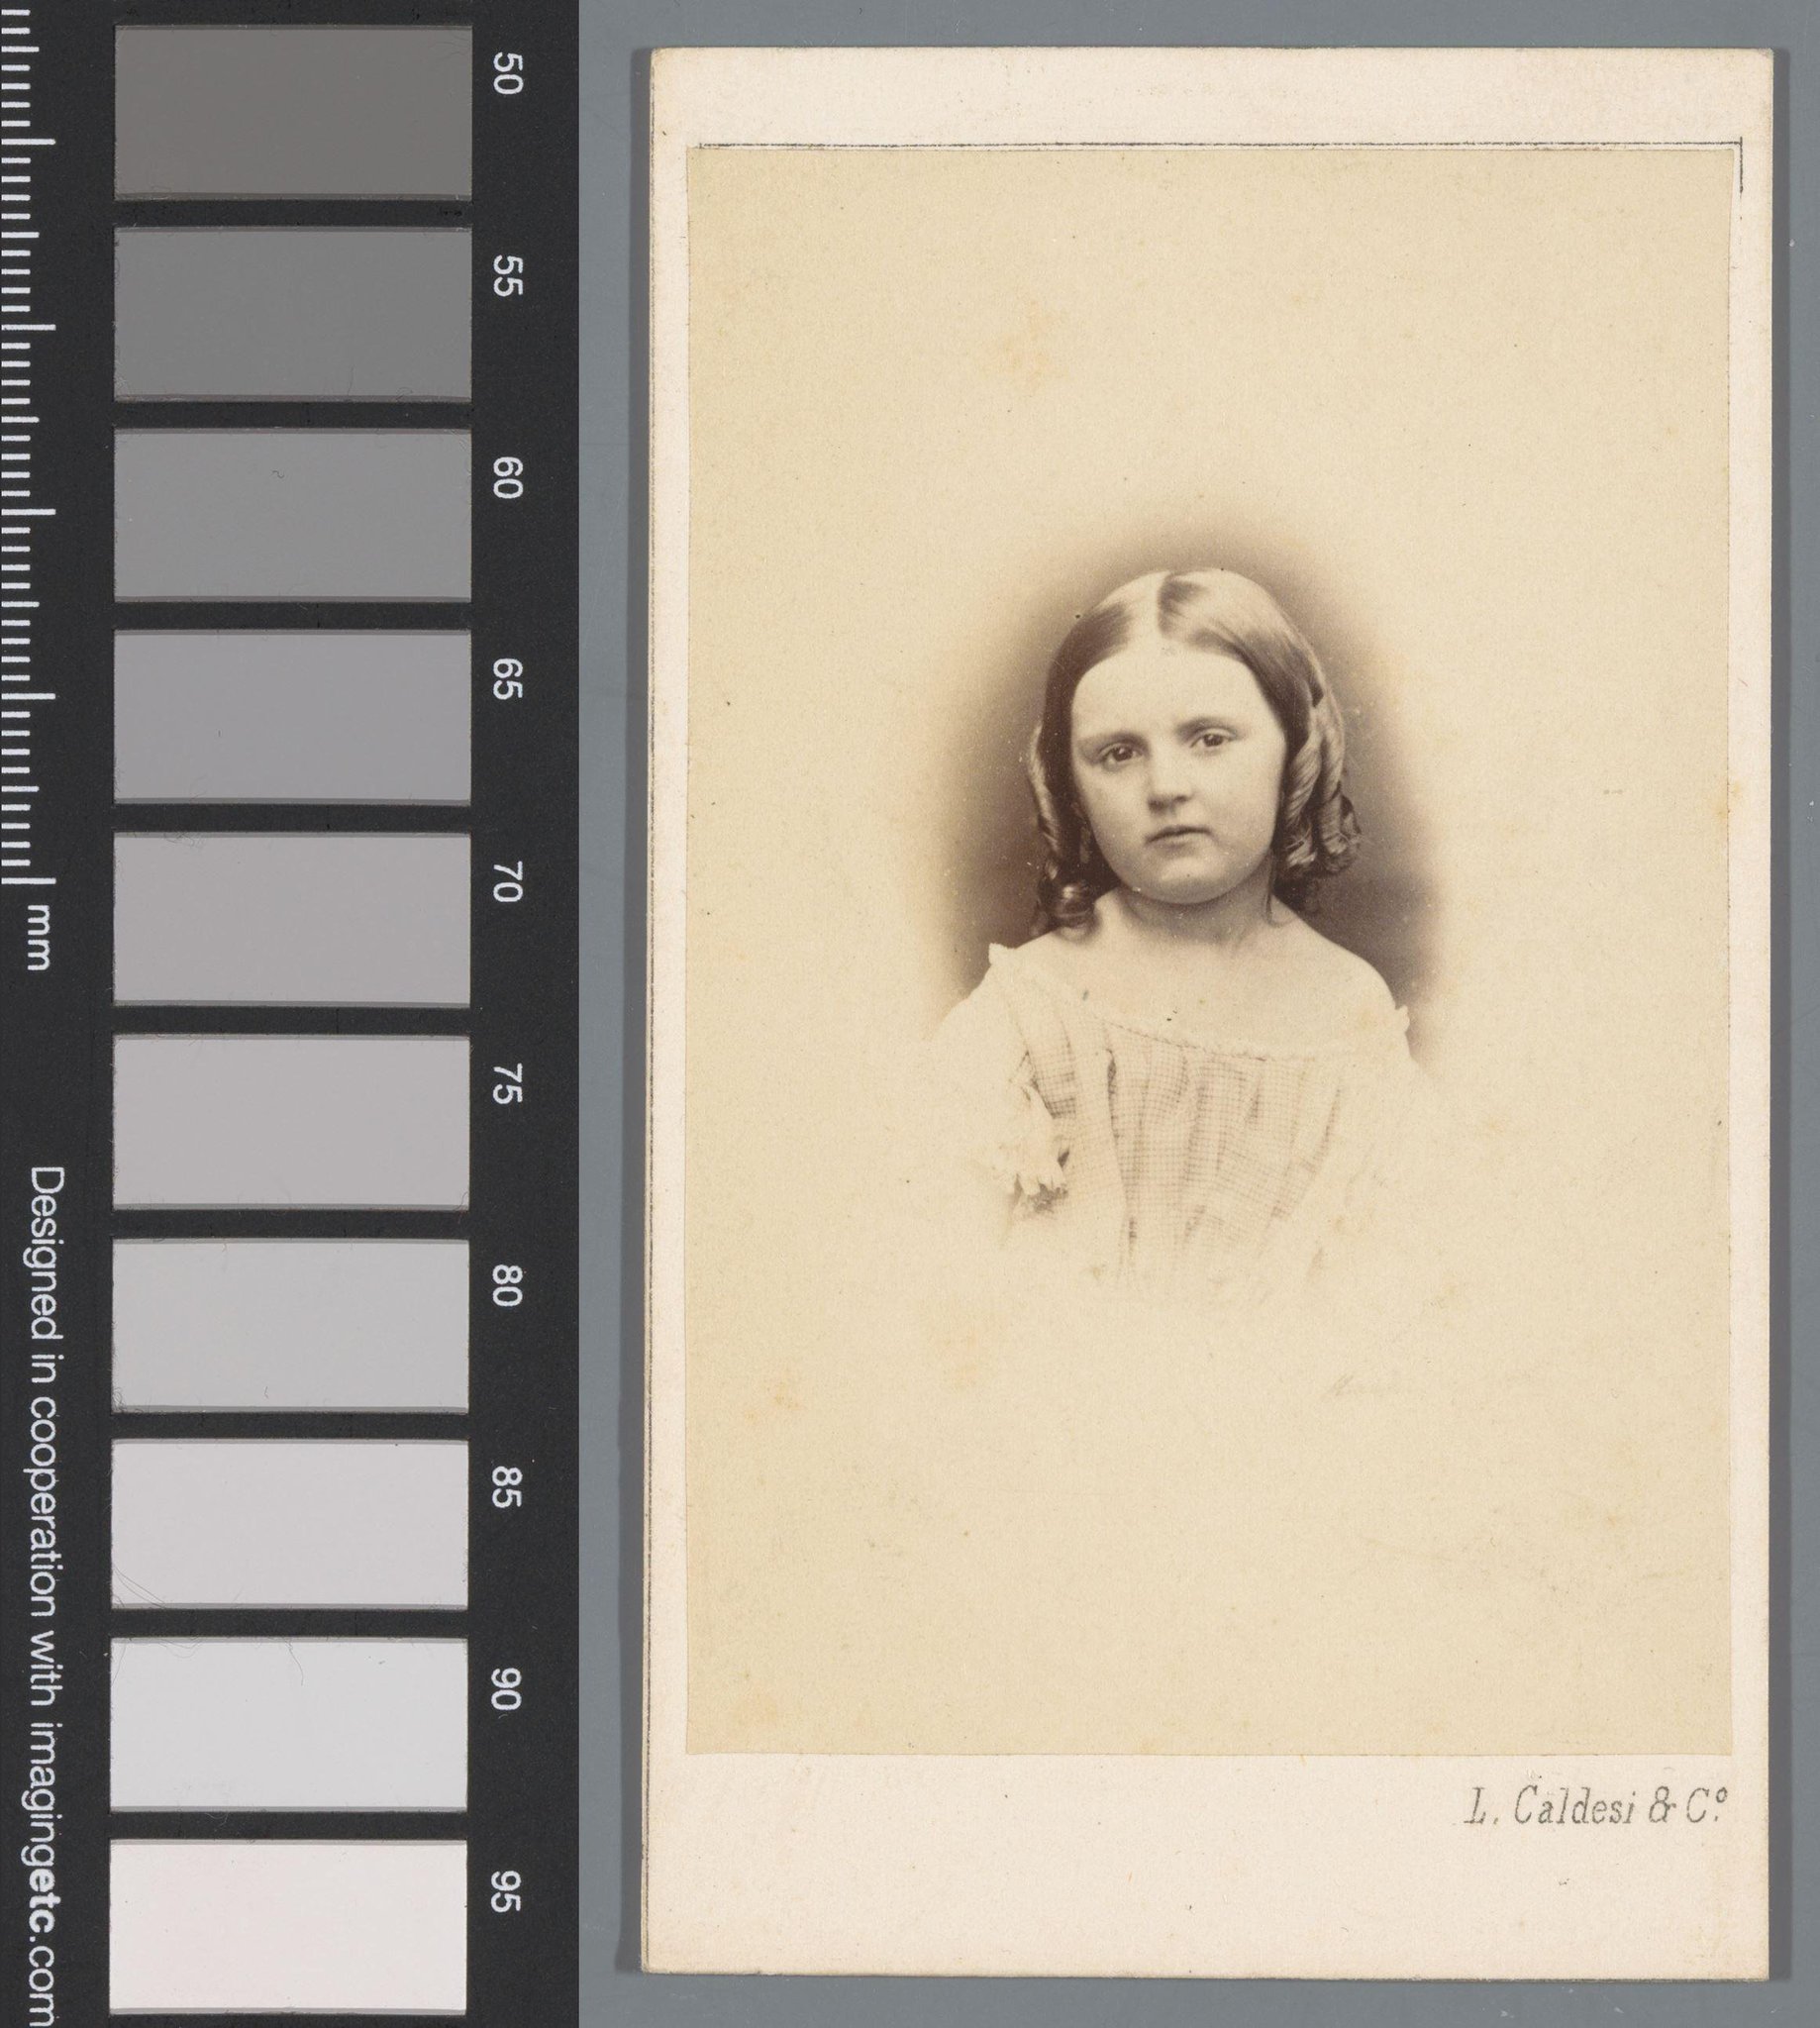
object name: carte de visite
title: Portret van Miss E. Hutton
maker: leonida caldesi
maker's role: fotograaf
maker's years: 1823-1891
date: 1861-1870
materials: cardboard, paper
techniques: albumen print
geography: london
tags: historical persons, girl (child between toddler and youth), london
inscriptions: inscription: ‘L. Caldesi & Co./ at/ P.D. Colnaghi, Scott & Co./ 13, Pall Mall East/ London’, inscription: ‘Miss E. Hutton/ 5520’, inscription: ‘L. Caldesi & Co.’